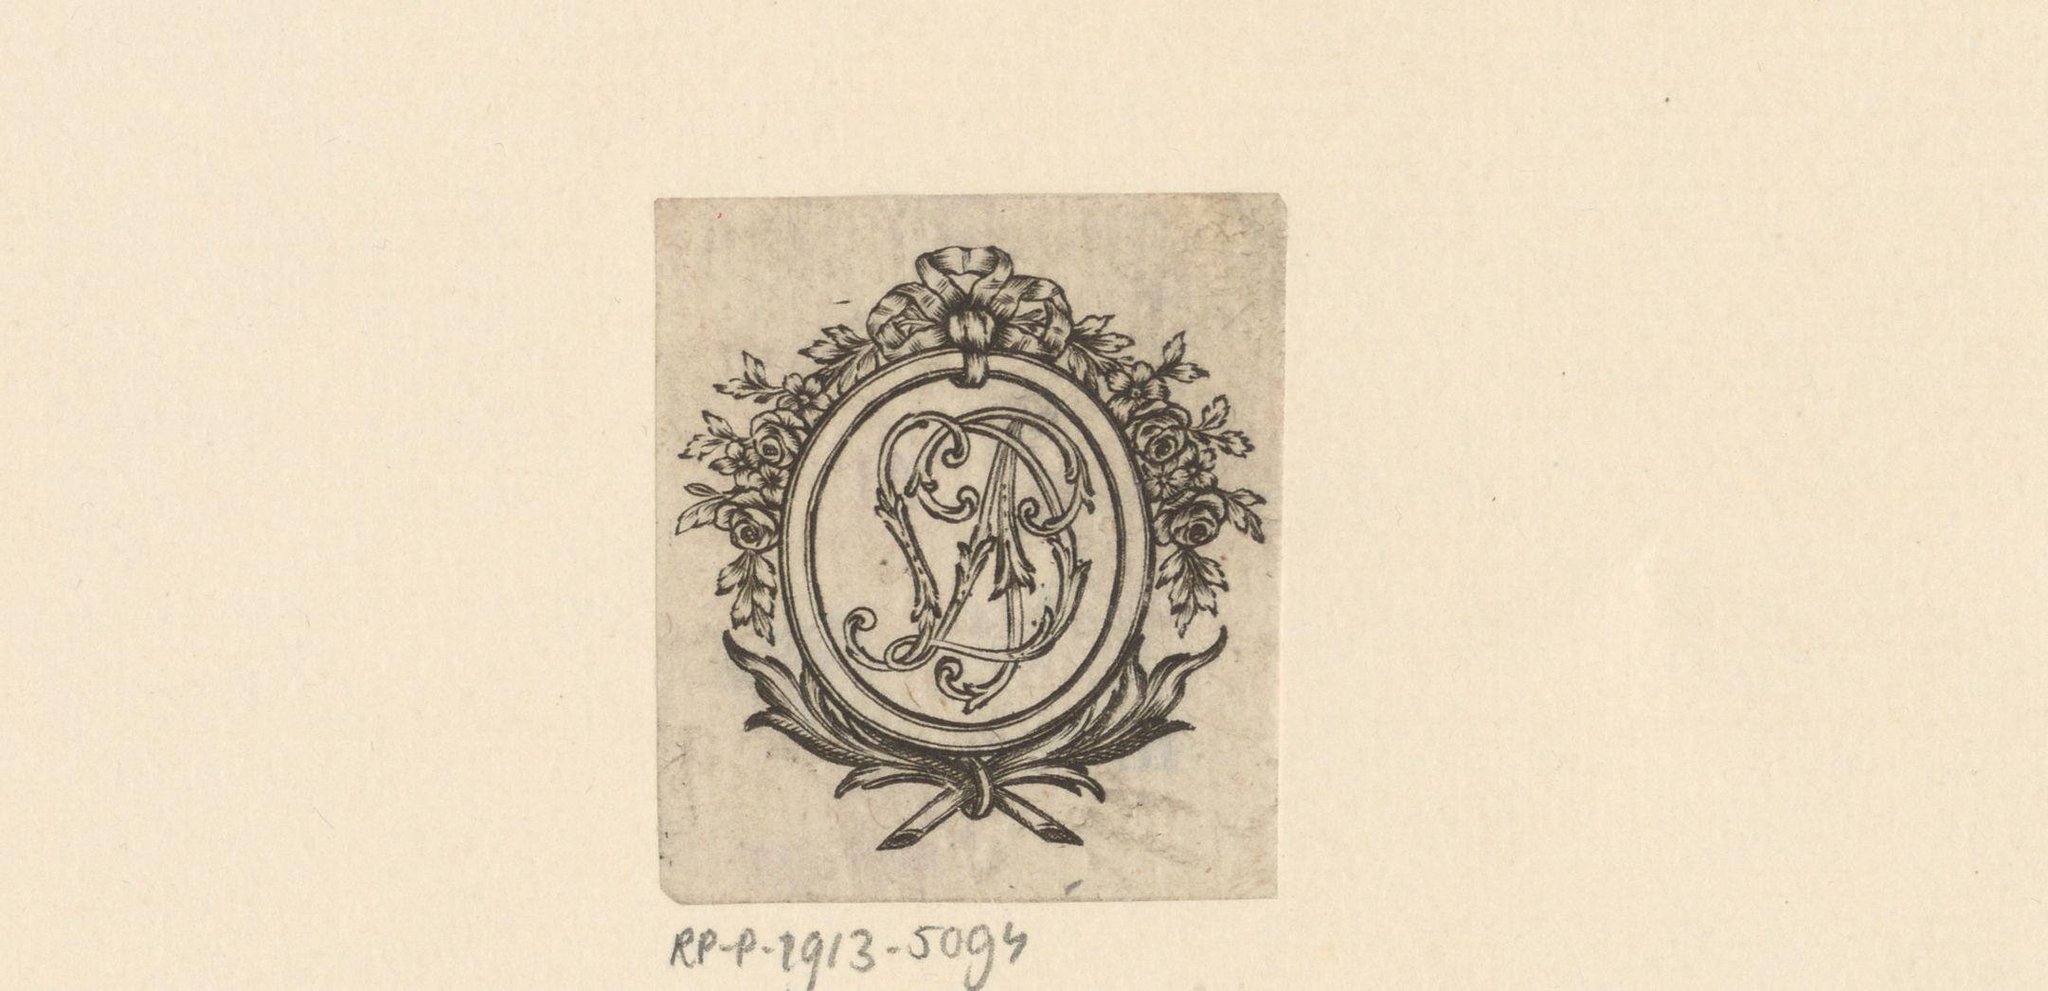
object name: bookplate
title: Ex libris van I.D.P.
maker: Anonymous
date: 1727-1787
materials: paper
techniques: etching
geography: netherlands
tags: amsterdam, the hague, palmette ~ ornament, flowers: rose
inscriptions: collector's mark: Lugt 2760, collector's mark: Lugt 2233